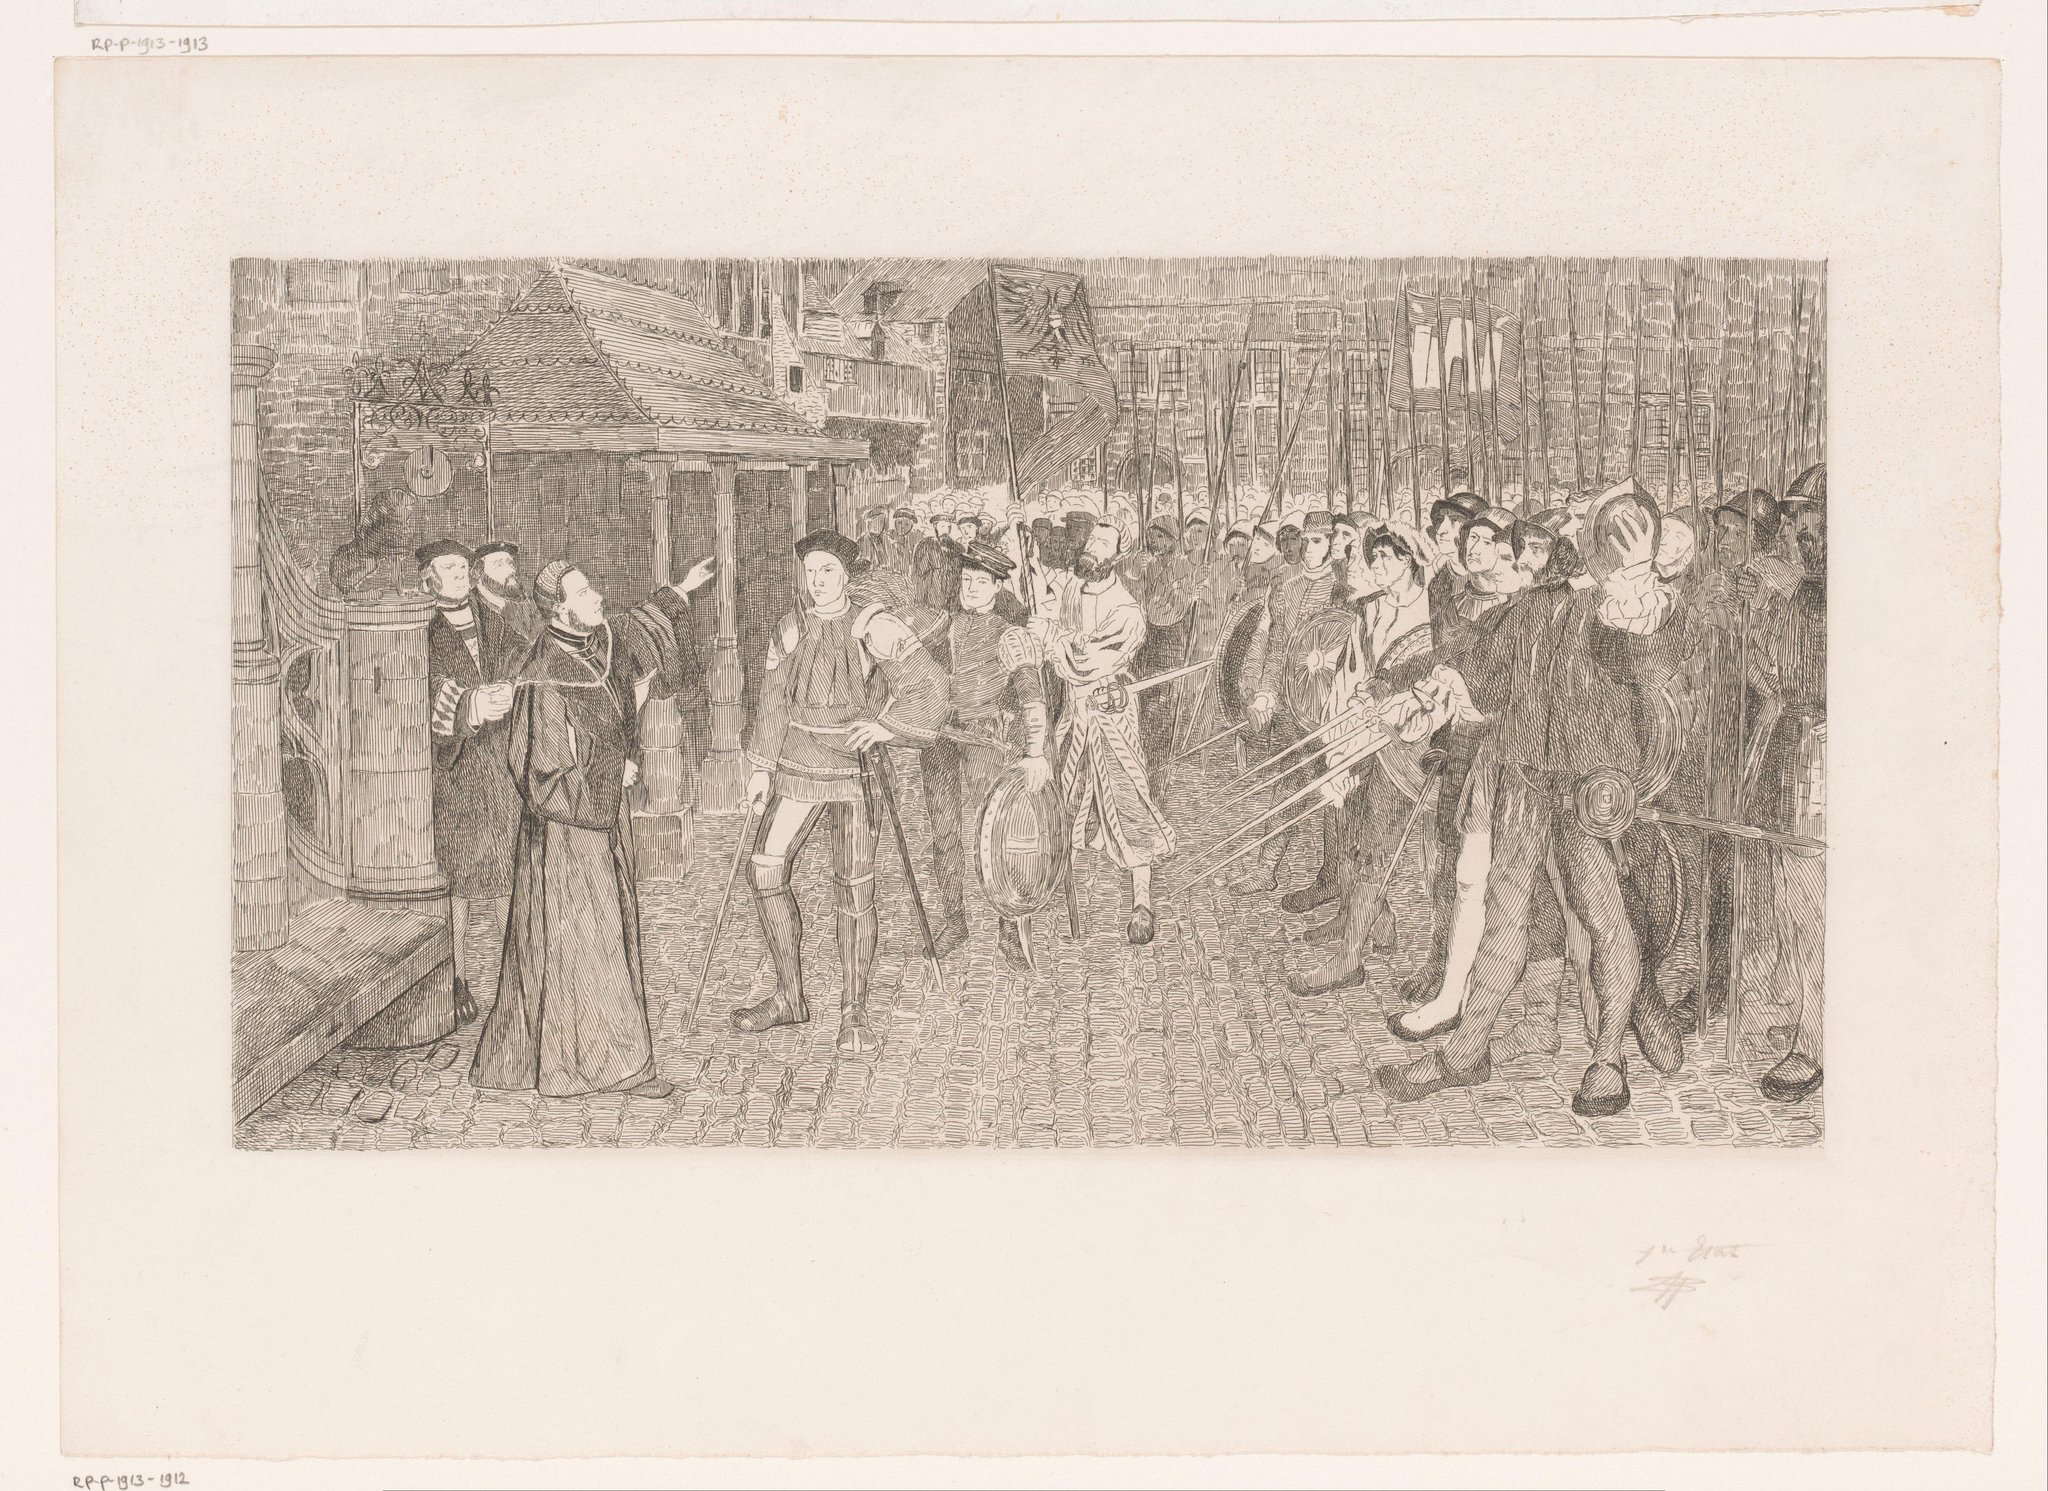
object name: print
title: Burgemeester Lancelot van Ursel geeft schepen Cornelis van Spangen het bevel over de burgerwacht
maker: jean baptiste pierre michiels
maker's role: print maker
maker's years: 1821-1890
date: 1863-1890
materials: paper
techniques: etching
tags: mayor, burgomaster, taking the oath ~ military service, meeting of soldiers and/or officers, antwerp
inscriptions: inscription: ‘1e Etat’, collector's mark: Lugt 2228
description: De burgerwacht werd in 1542 ingezet ter verdediging van de stad Antwerpen tegen Maarten van Rossum. De prent is gemaakt naar de muurschilderingen van Henri Leys in het Stadhuis van Antwerpen. Een latere staat van de plaat is gebruikt in: Leys, Henri. De Zaal Leys op het Stadhuis van Antwerpen: zeven kopersneden naar de muurschilderingen van Baron H. Leys. Antwerpen: Museum Plantin-Moretus, 1902.